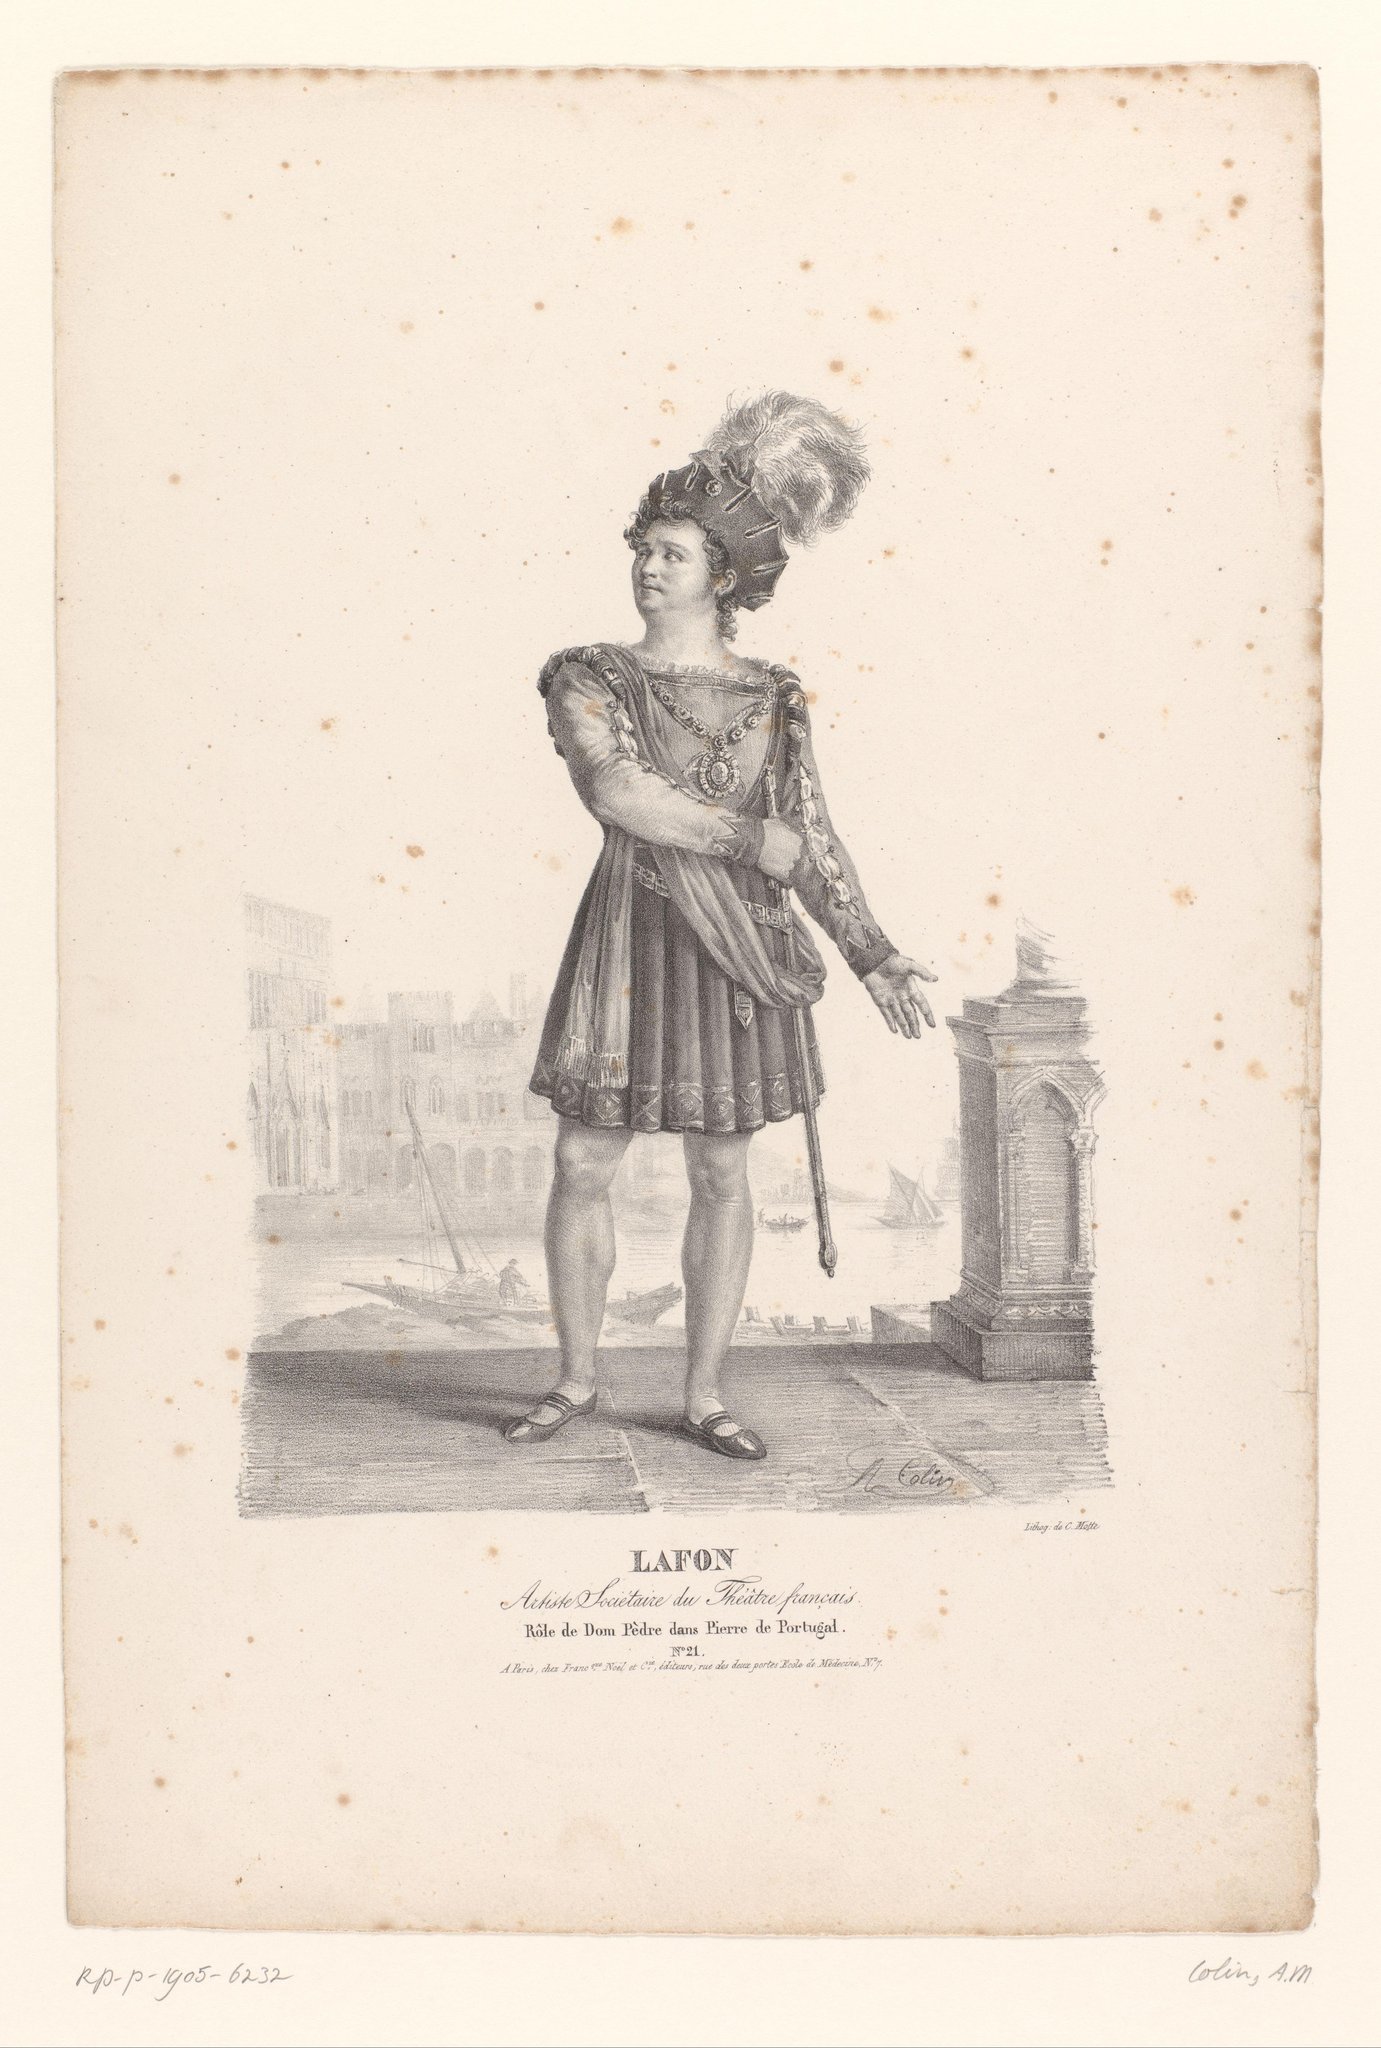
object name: print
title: Lafon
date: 1824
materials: paper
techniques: lithograph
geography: paris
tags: stage costume, portrait of actor, actress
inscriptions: collector's mark: Lugt 2228a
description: Don Pèdre is een personage uit de tragedie 'Pierre de Portugal' van Lucien Arnault. Opgevoerd door het Théâtre Français in Parijs in 1823.